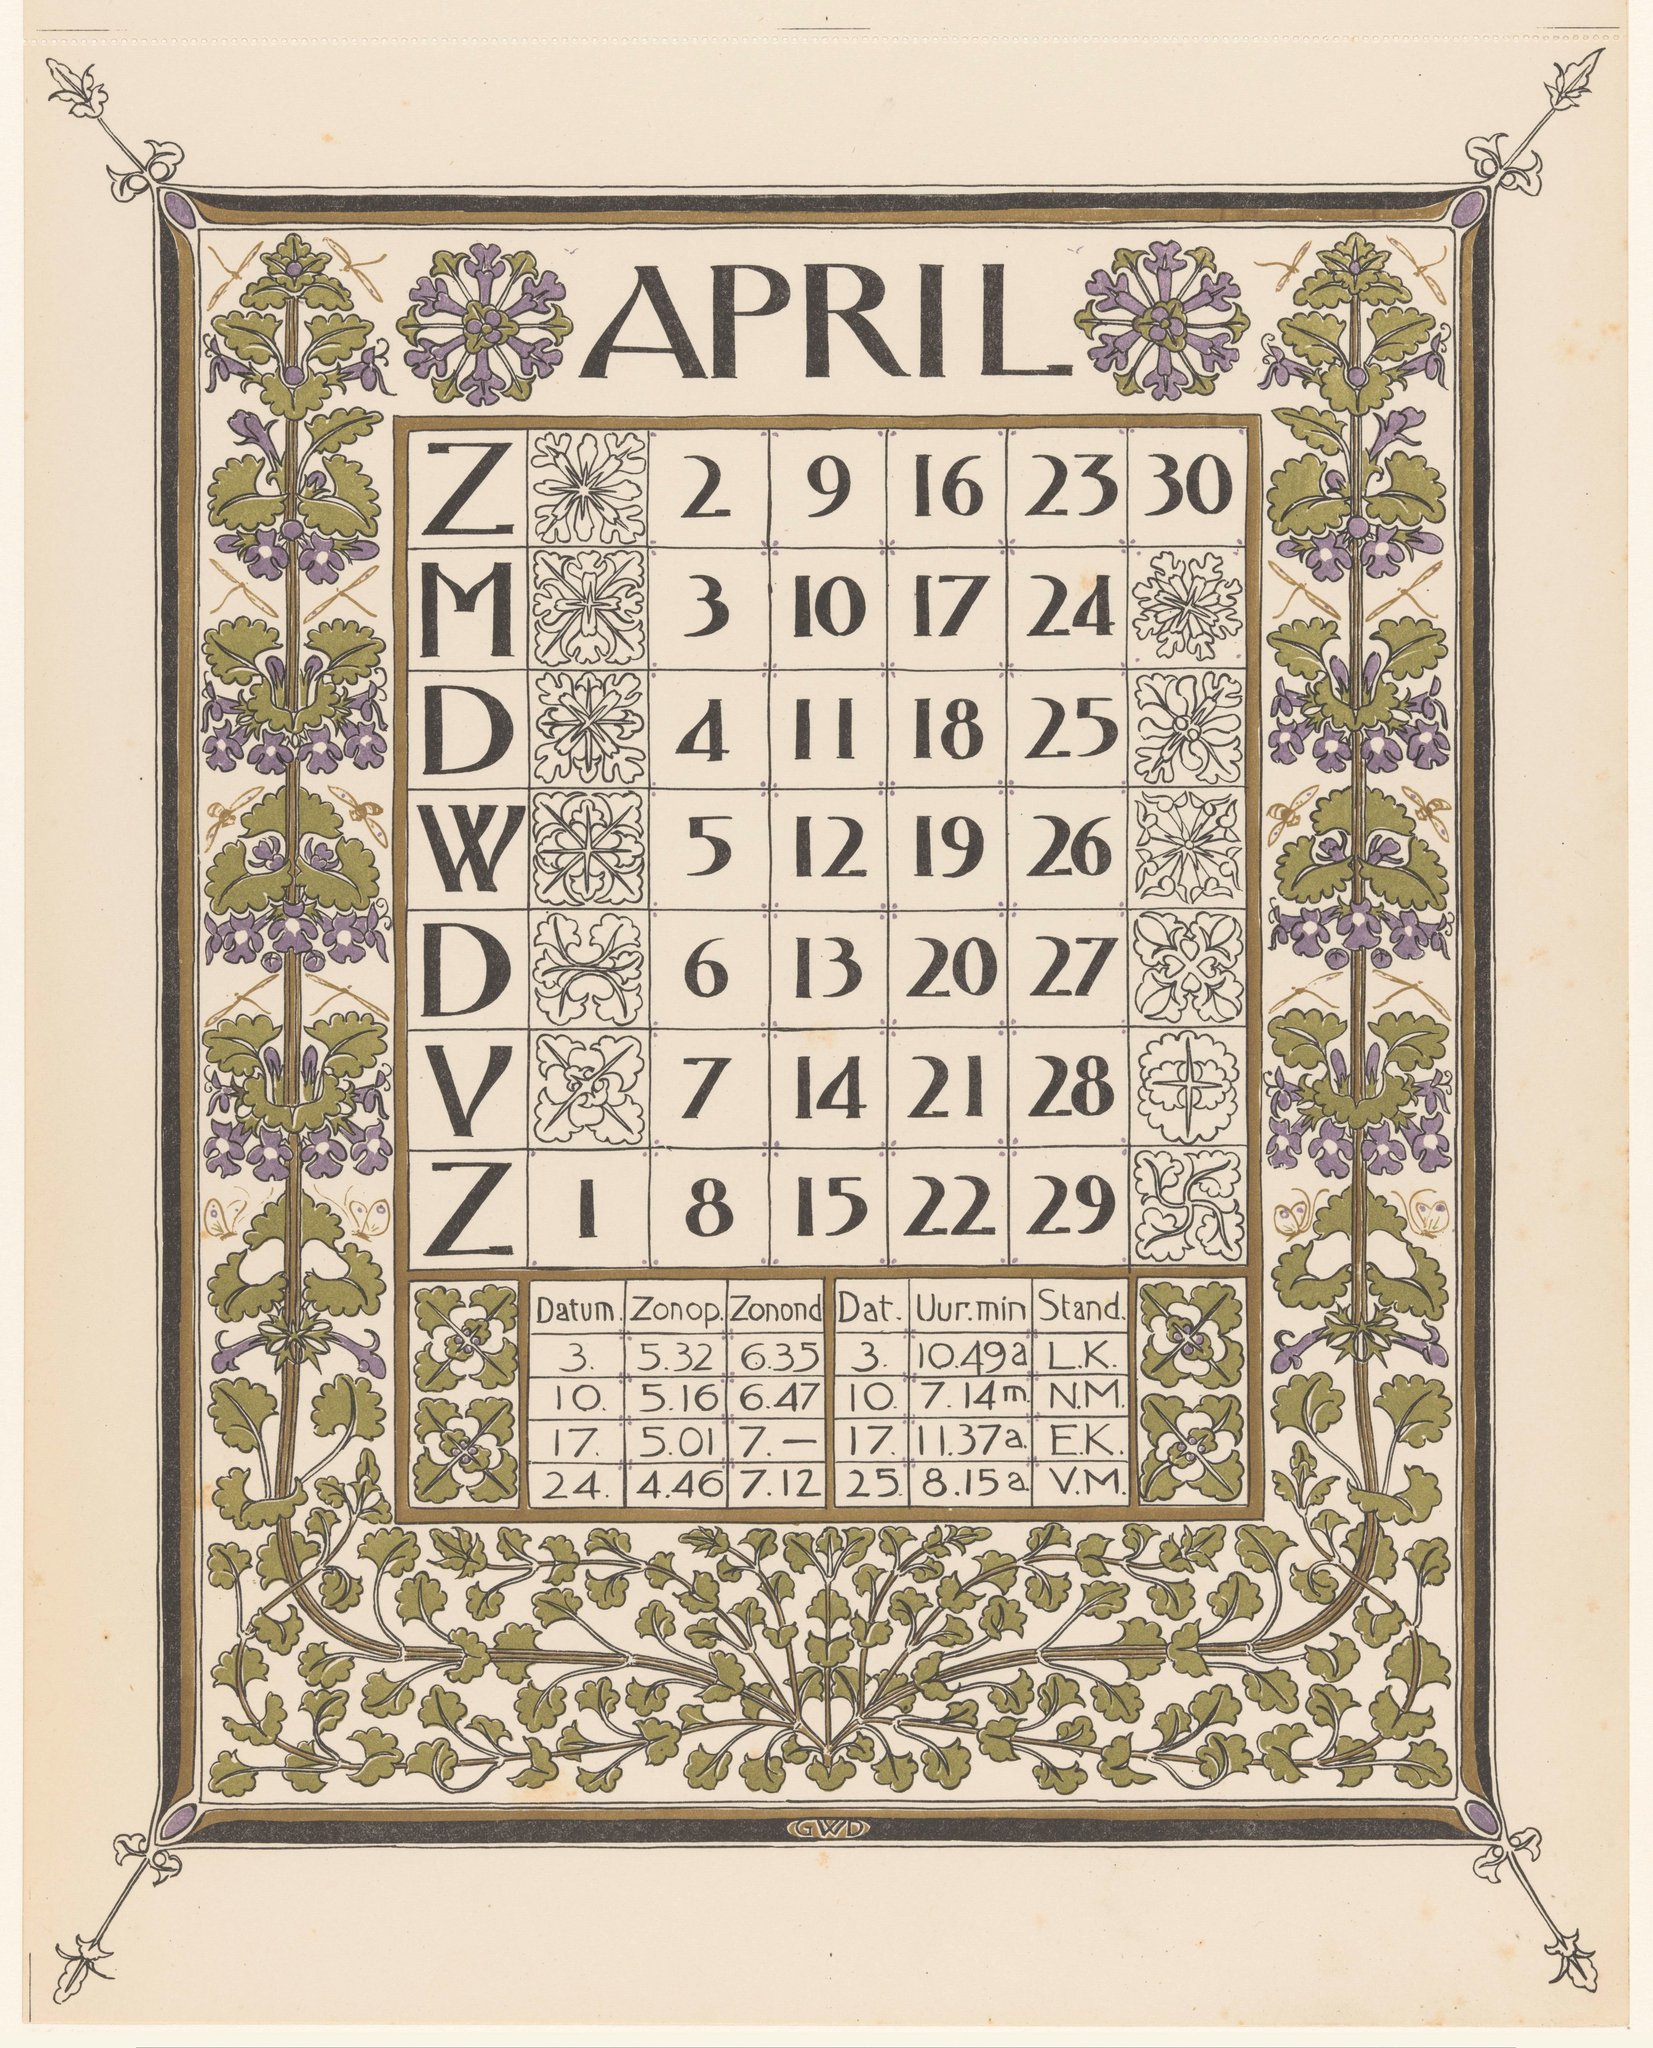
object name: print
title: Kalenderblad voor april 1899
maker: gerrit willem dijsselhof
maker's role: designer, draughtsman, print maker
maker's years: 1866-1924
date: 1898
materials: paper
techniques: lithograph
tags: ornaments ~ art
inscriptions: collector's mark: Lugt 2228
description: In 1898 vervaardigden Gerrit Willem Dijsselhof, Carel Adolph Lion Cachet en Theo Nieuwenhuis samen een kalender voor het jaar 1899. Dijsselhof nam het ontwerp van de maanden januari, april, juli en oktober op zich.